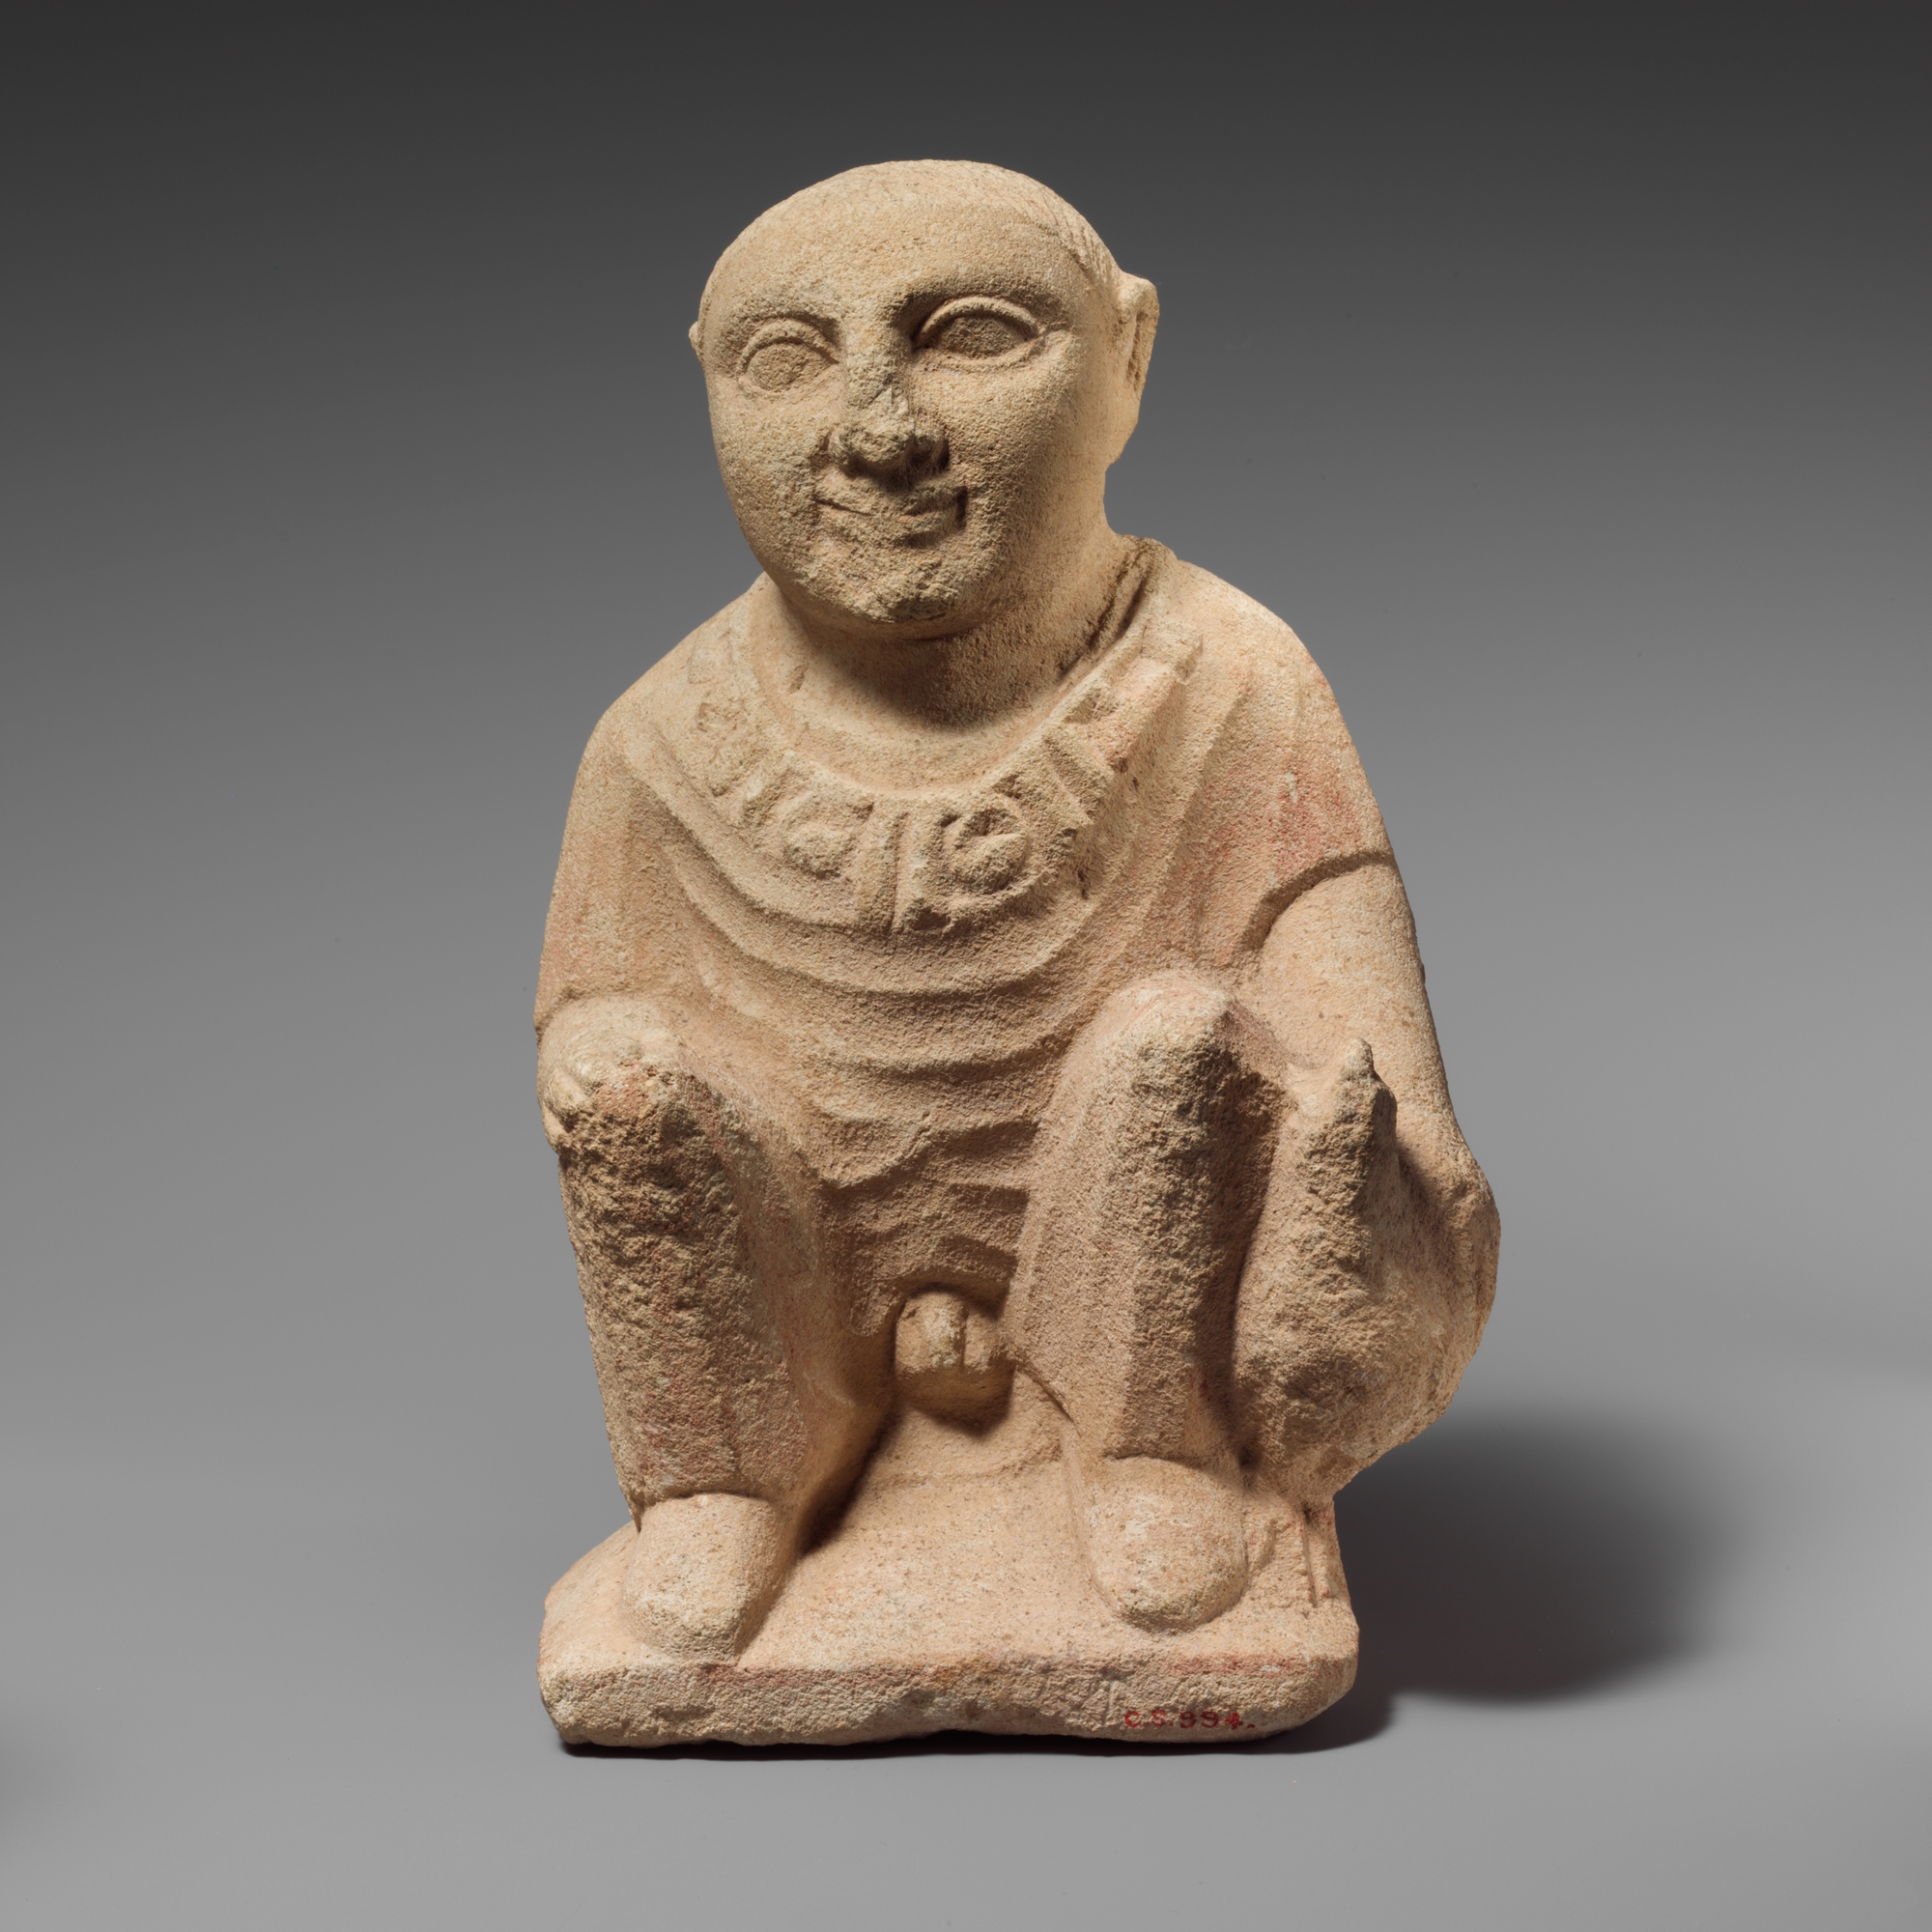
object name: statuette of a temple boy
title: Limestone statuette of a temple boy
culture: cypriot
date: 400-301 BCE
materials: limestone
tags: necklaces,boys